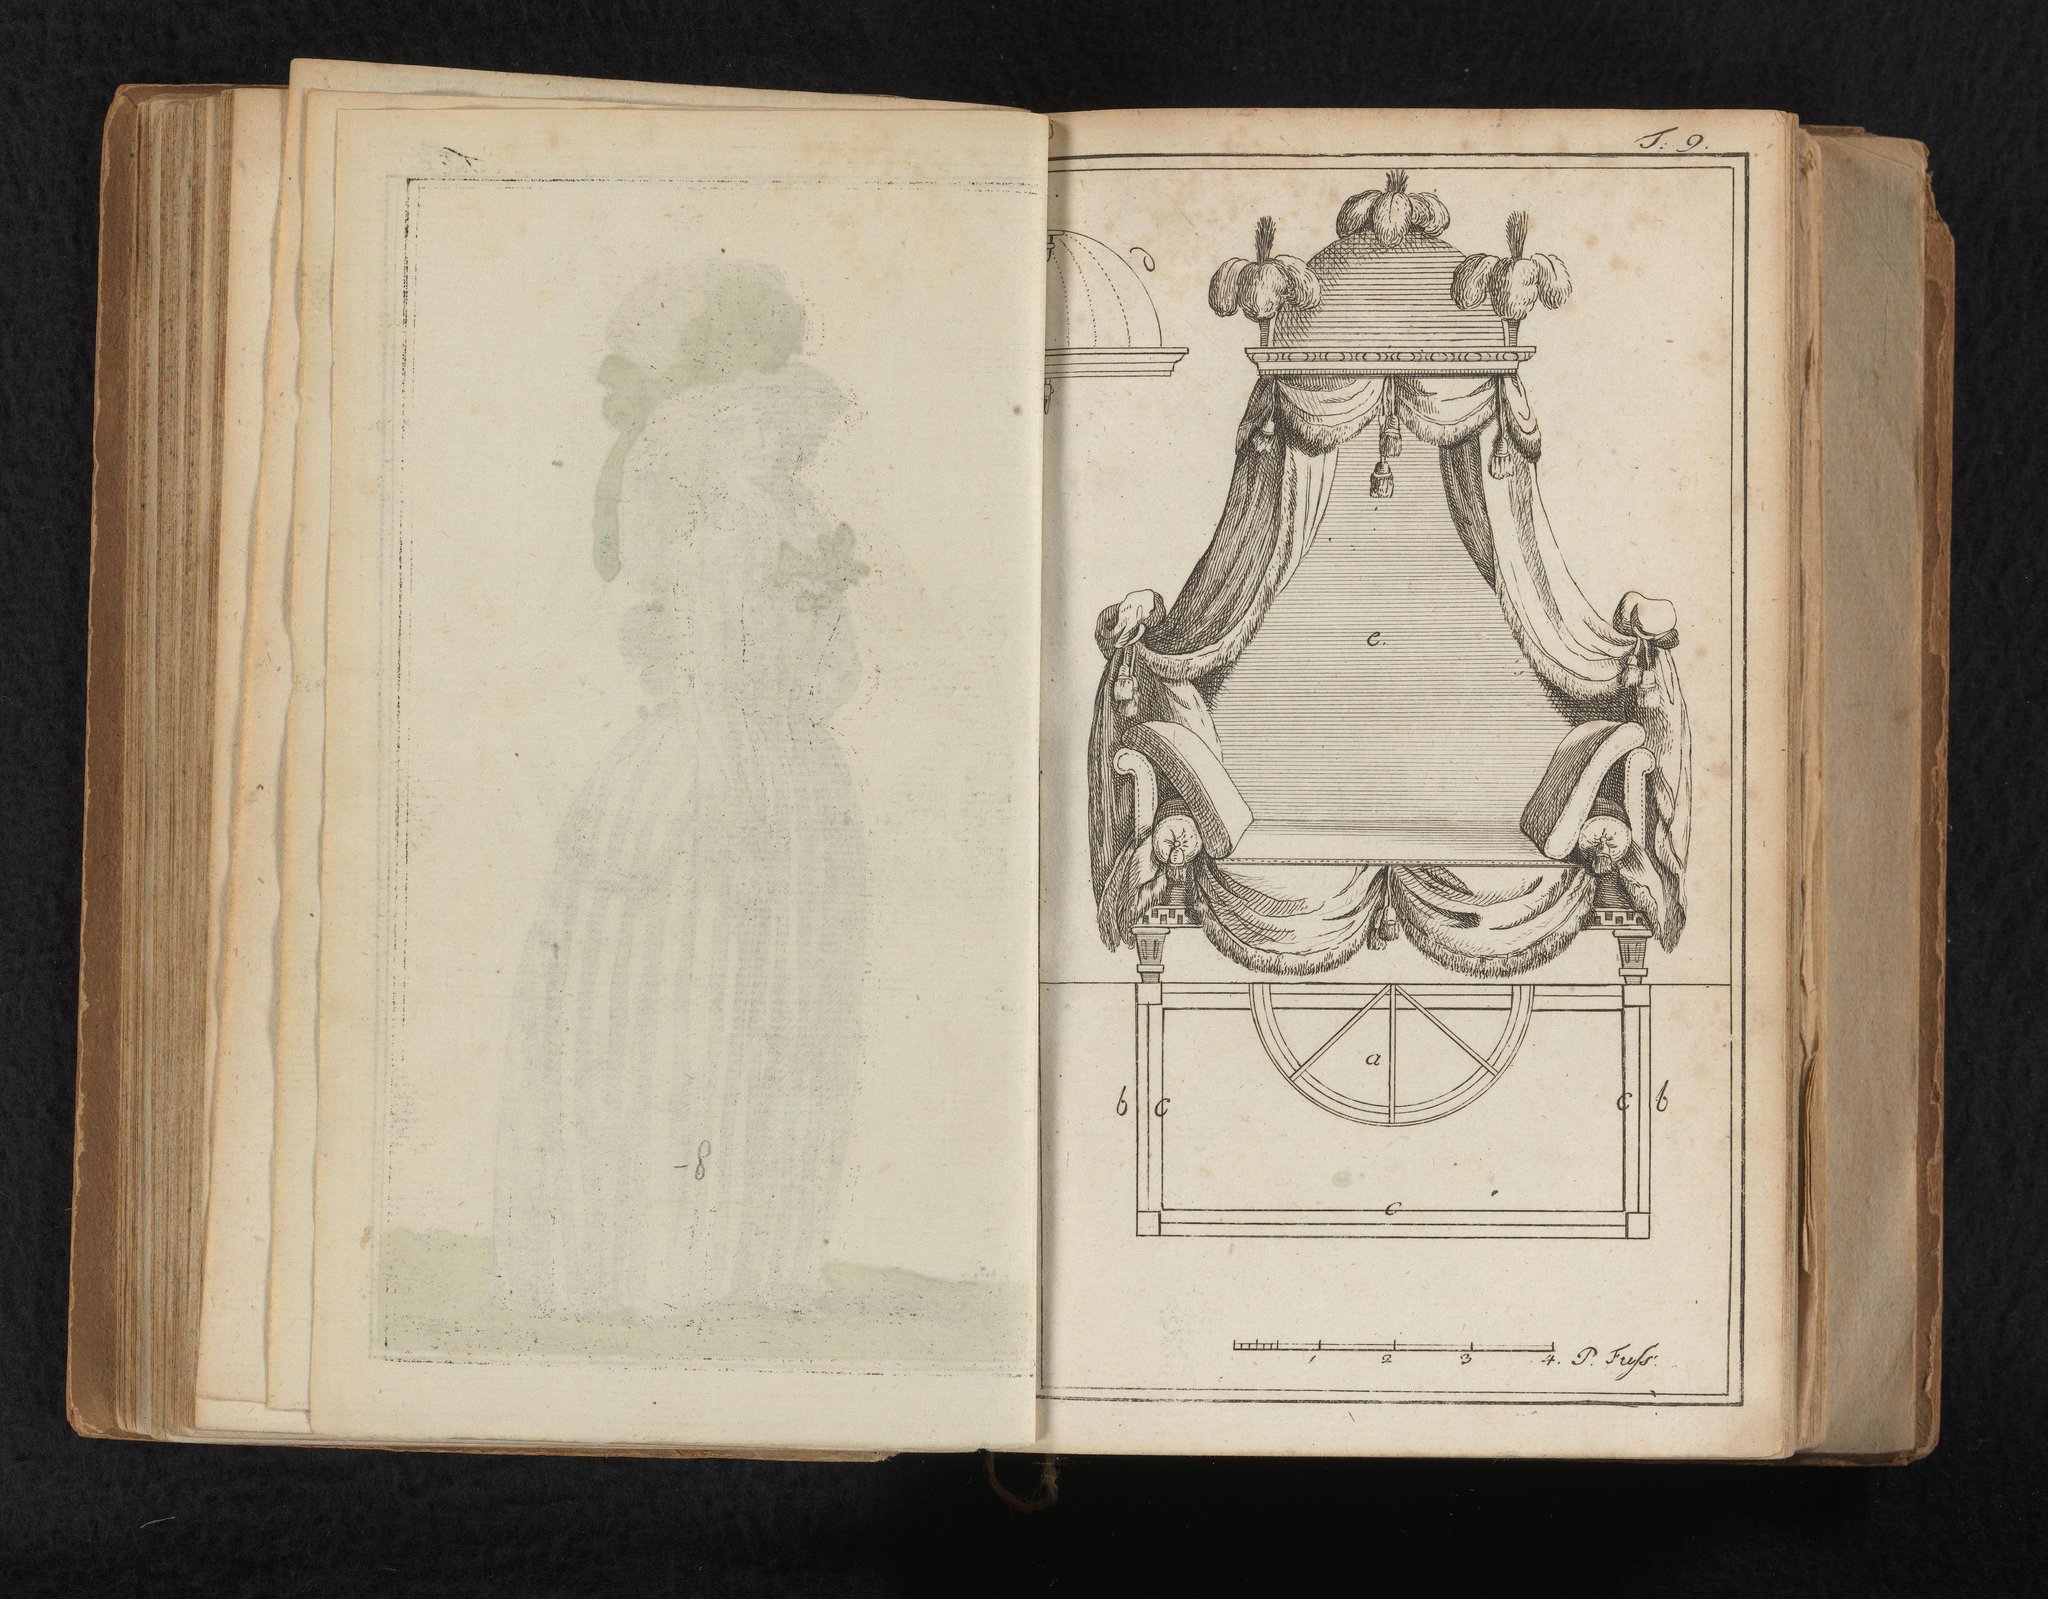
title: Journal des Luxus und der Moden 1788, Band III, T.9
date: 1788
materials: paper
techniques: etching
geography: weimar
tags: fashion plates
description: Ameublement: een rustbed 'a la Turque'. Prent uit het modetijdschrift Journal des Luxus und der Moden, uitgegeven door Friedrich Justin Bertuch en Georg Melchior Kraus, Weimar, 1786-1826.